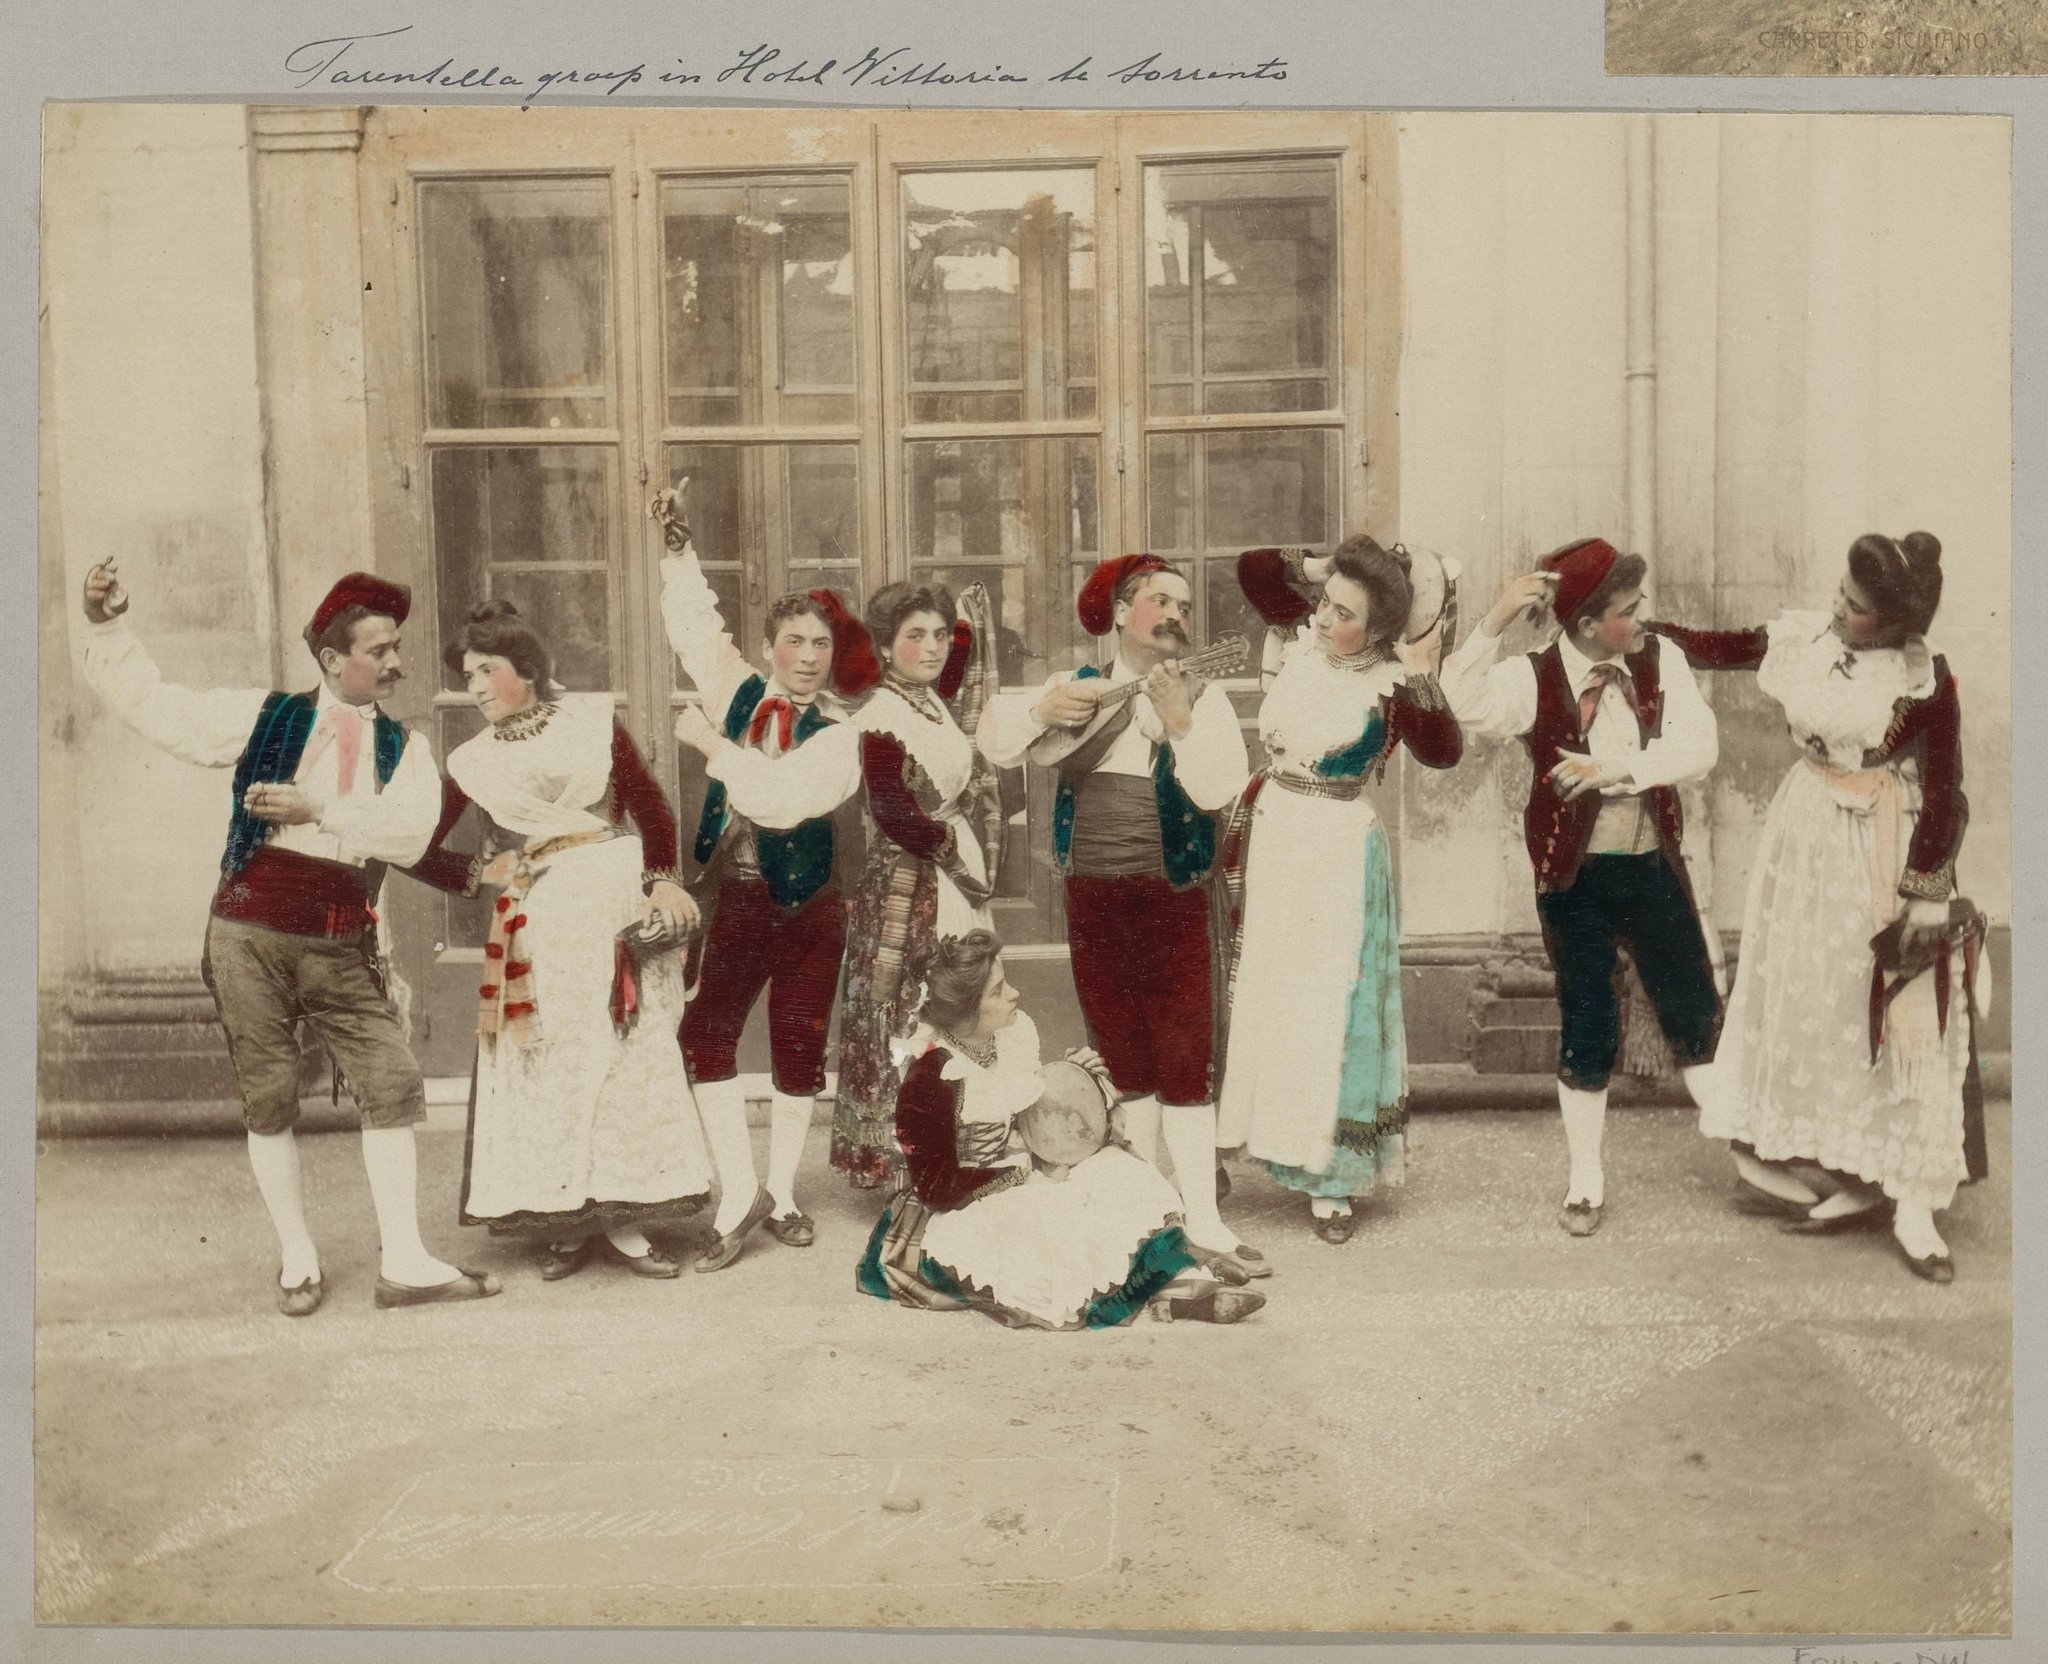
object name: photograph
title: Tarentellagroep, dansend bij hotel Cocumella in Sorrento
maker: Anonymous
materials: photographic support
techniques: albumen print, hand coloring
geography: sorrento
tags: dancing, sorrento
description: Onderdeel van Fotoalbum van een reis door Zuid-Europa en het Midden-Oosten.